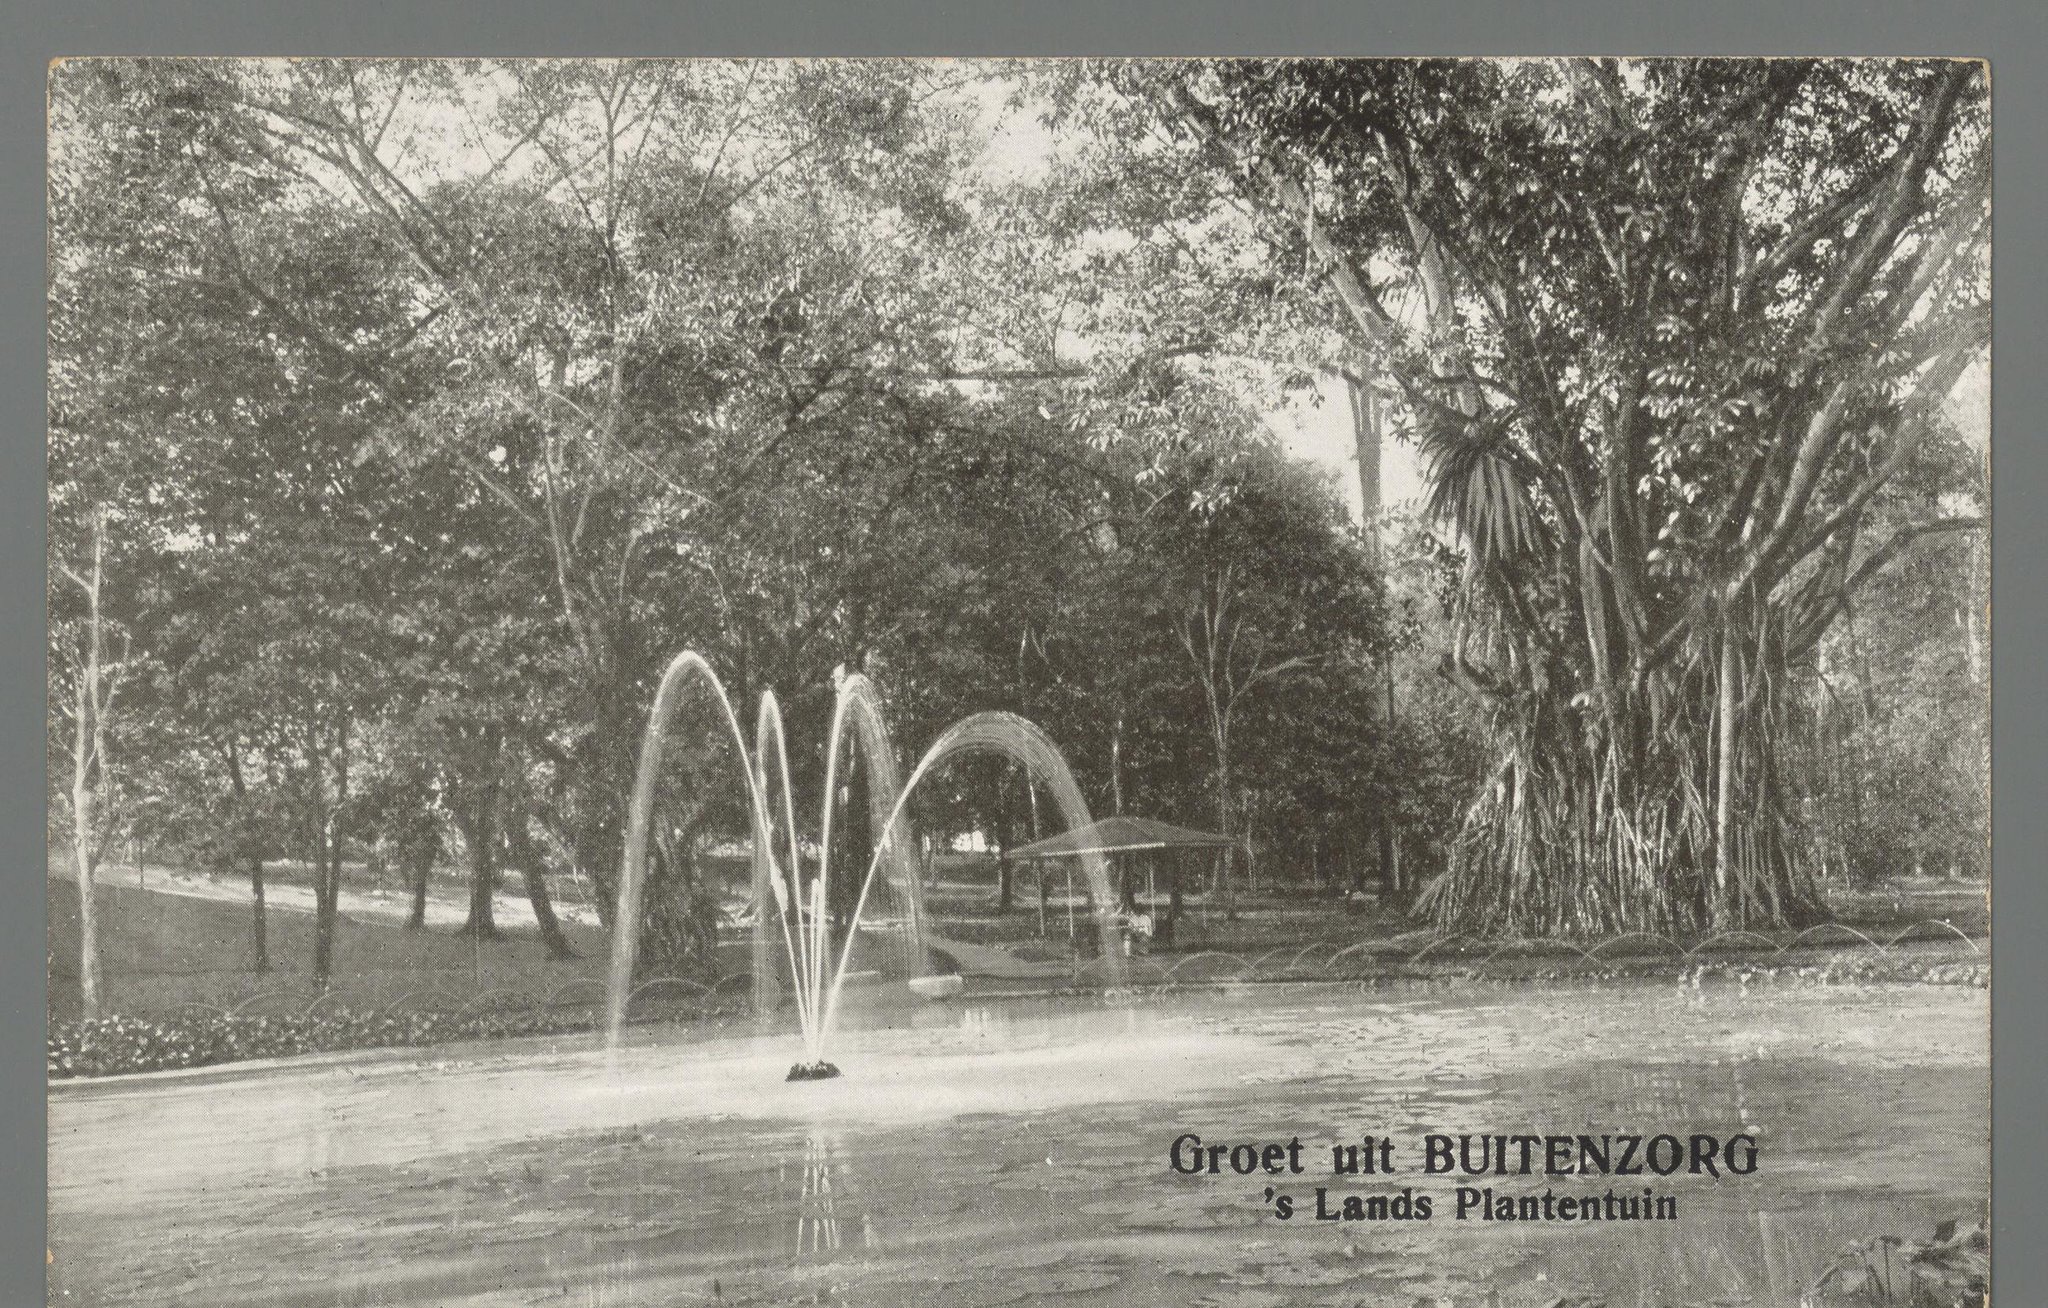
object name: ansichtkaart, prentbriefkaart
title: Groet uit Buitenzorg. 's Lands Plantentuin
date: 1906-1930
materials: cardboard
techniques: autotype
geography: buitenzorg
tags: trees, garden fountain, botanic garden, 'hortus botanicus', pond